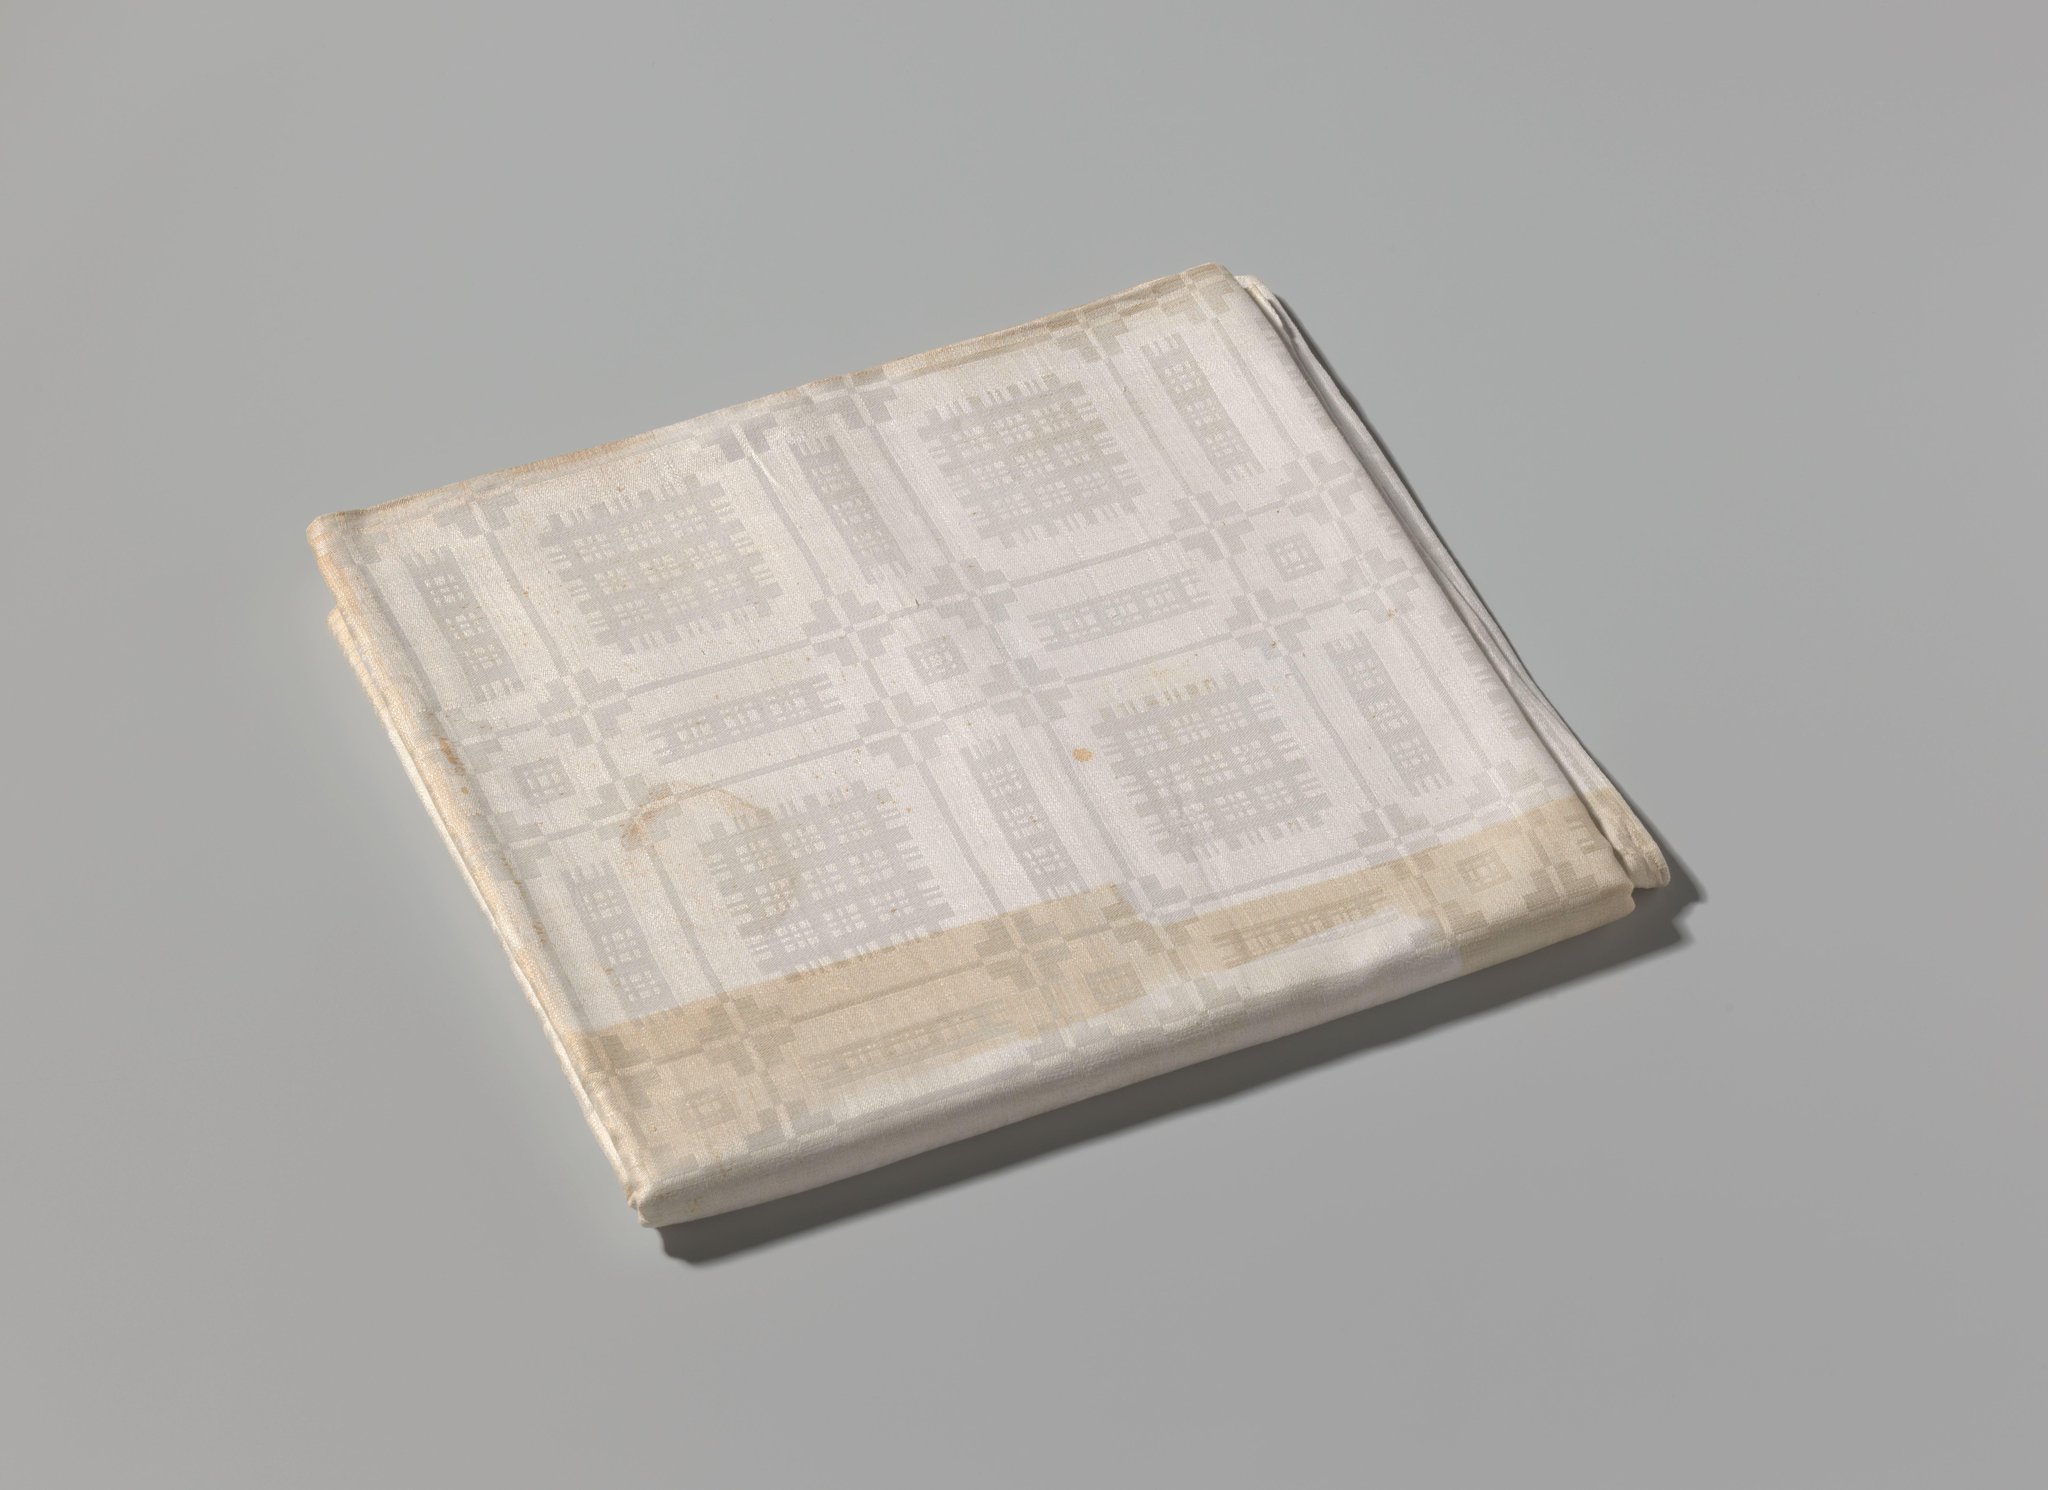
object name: napkin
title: Wit linnen pellen servet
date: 1800-1850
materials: linen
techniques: peeled fabric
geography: northern netherlands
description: Wit linnen pellen servet, gemerkt kroon H.